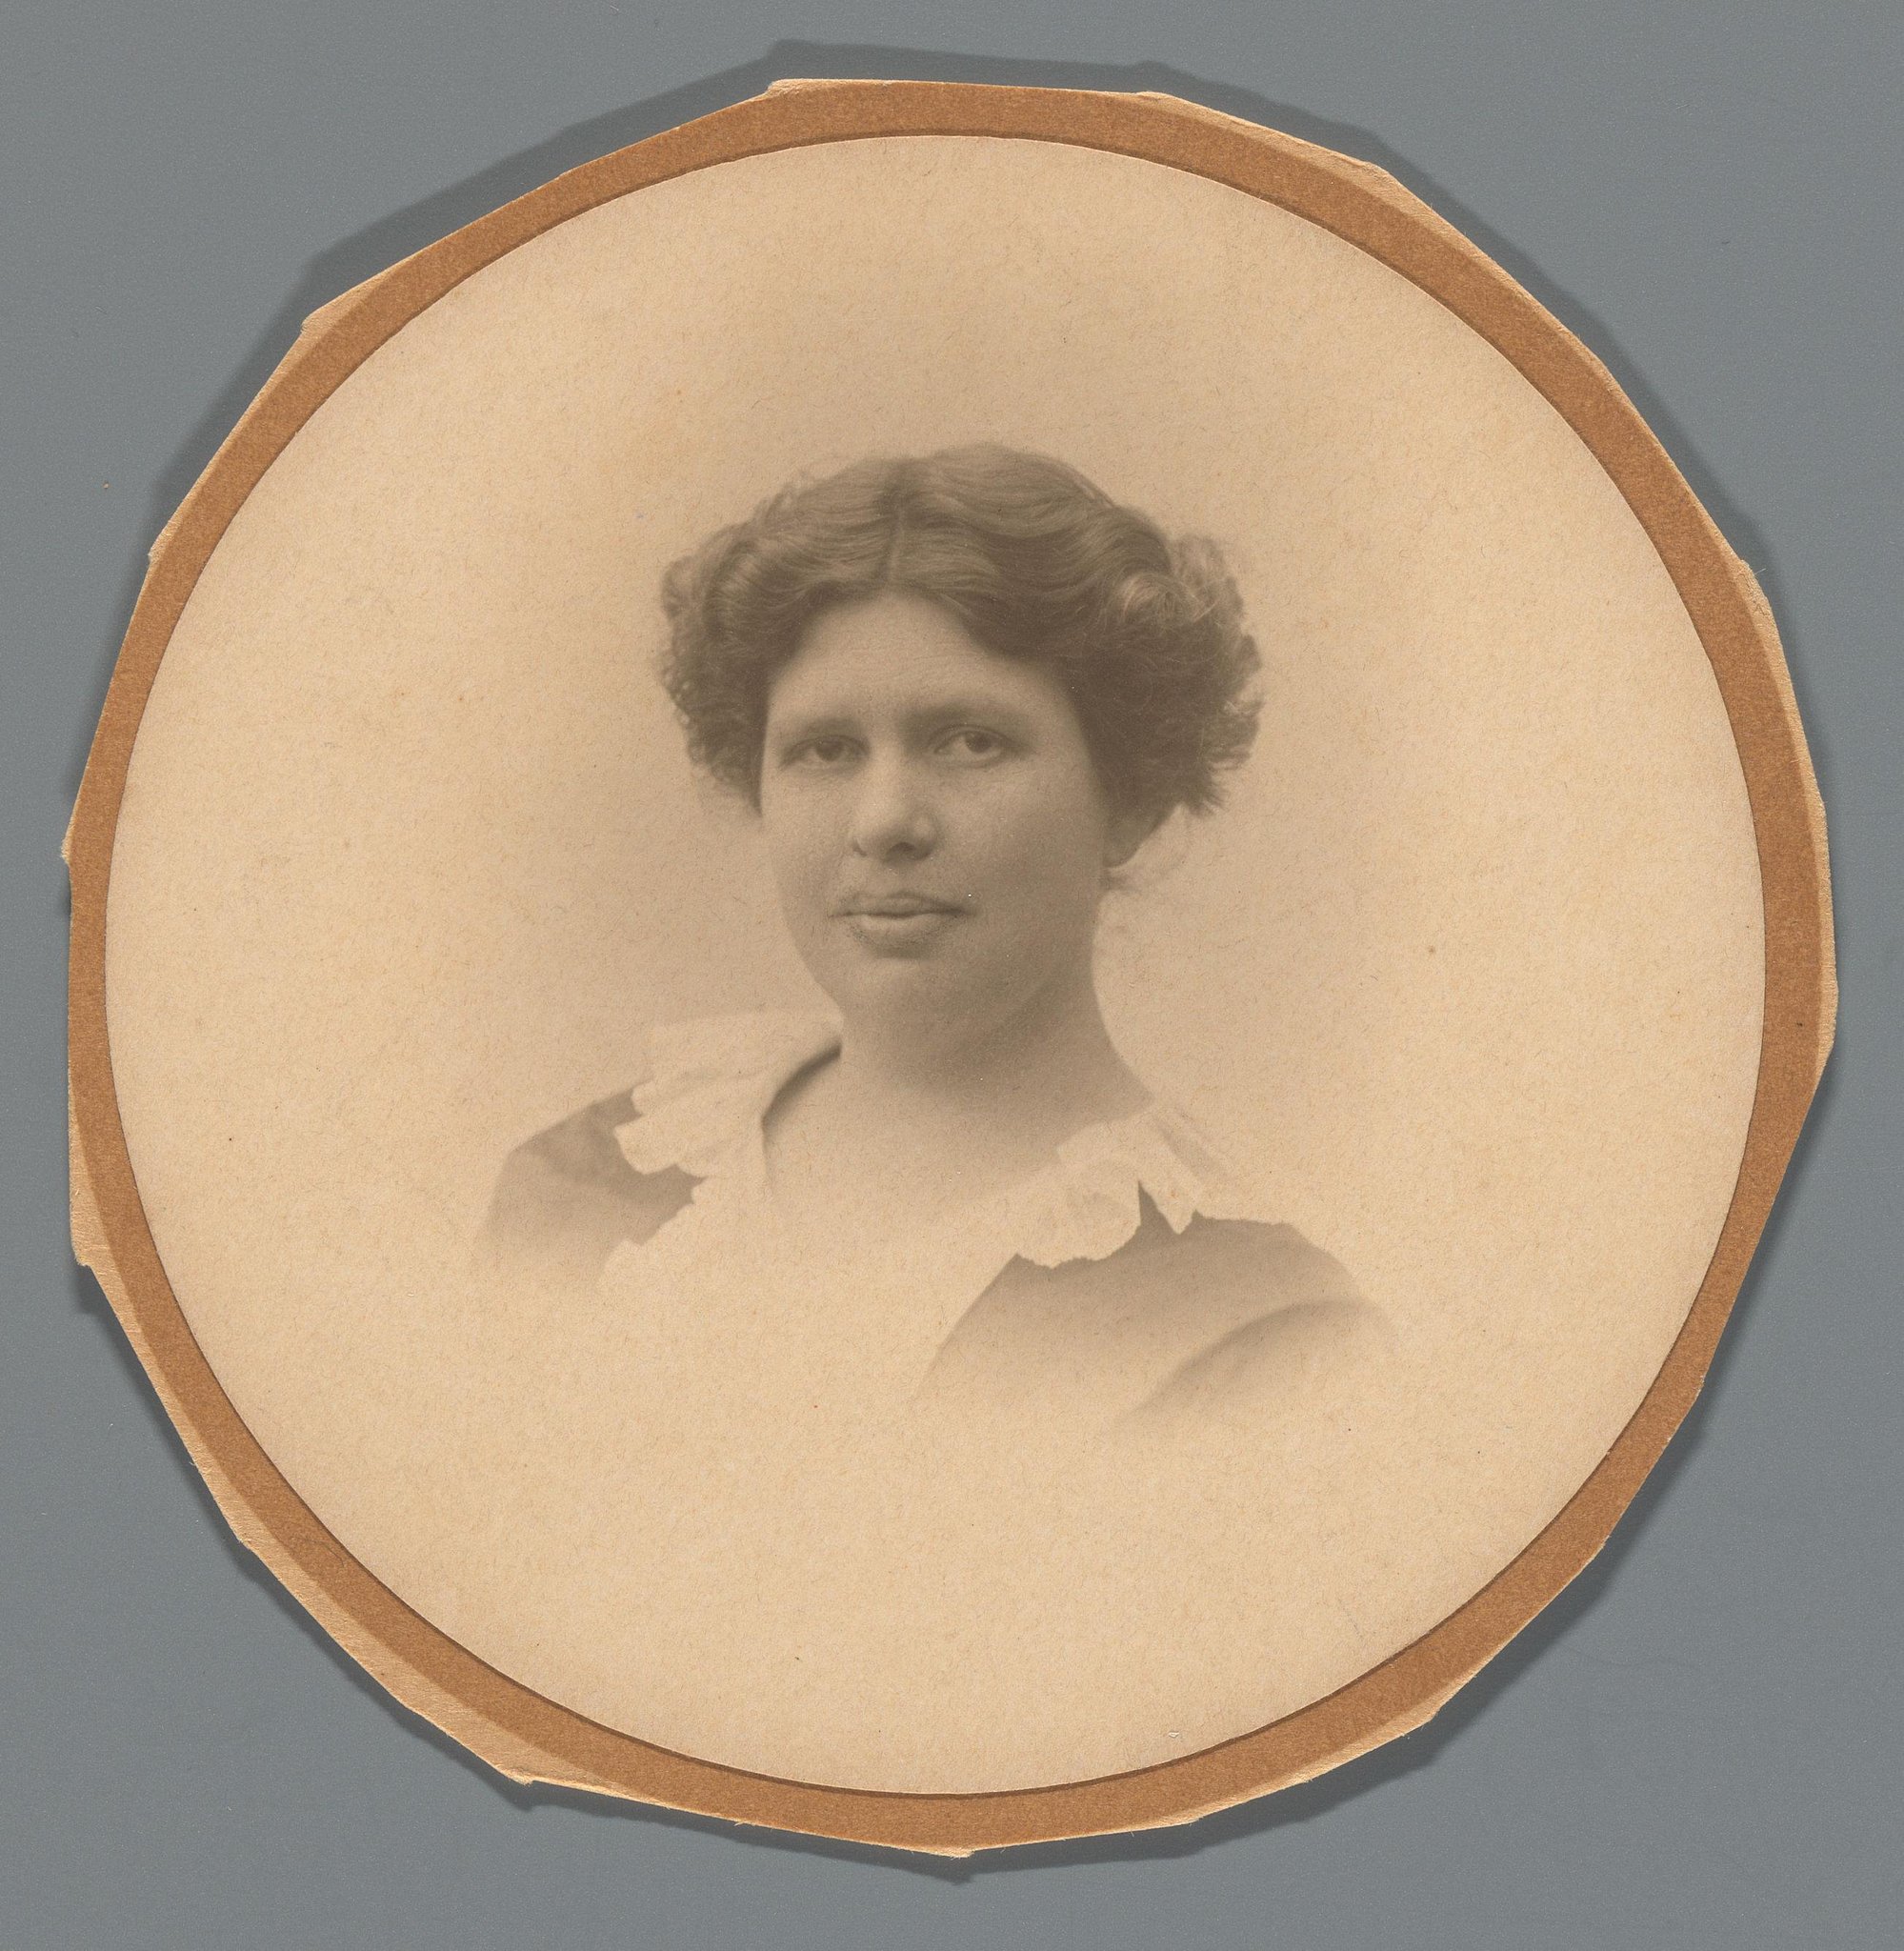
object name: photograph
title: Portret van tante Leo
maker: Anonymous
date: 1880-1920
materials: cardboard, photographic support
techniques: photography